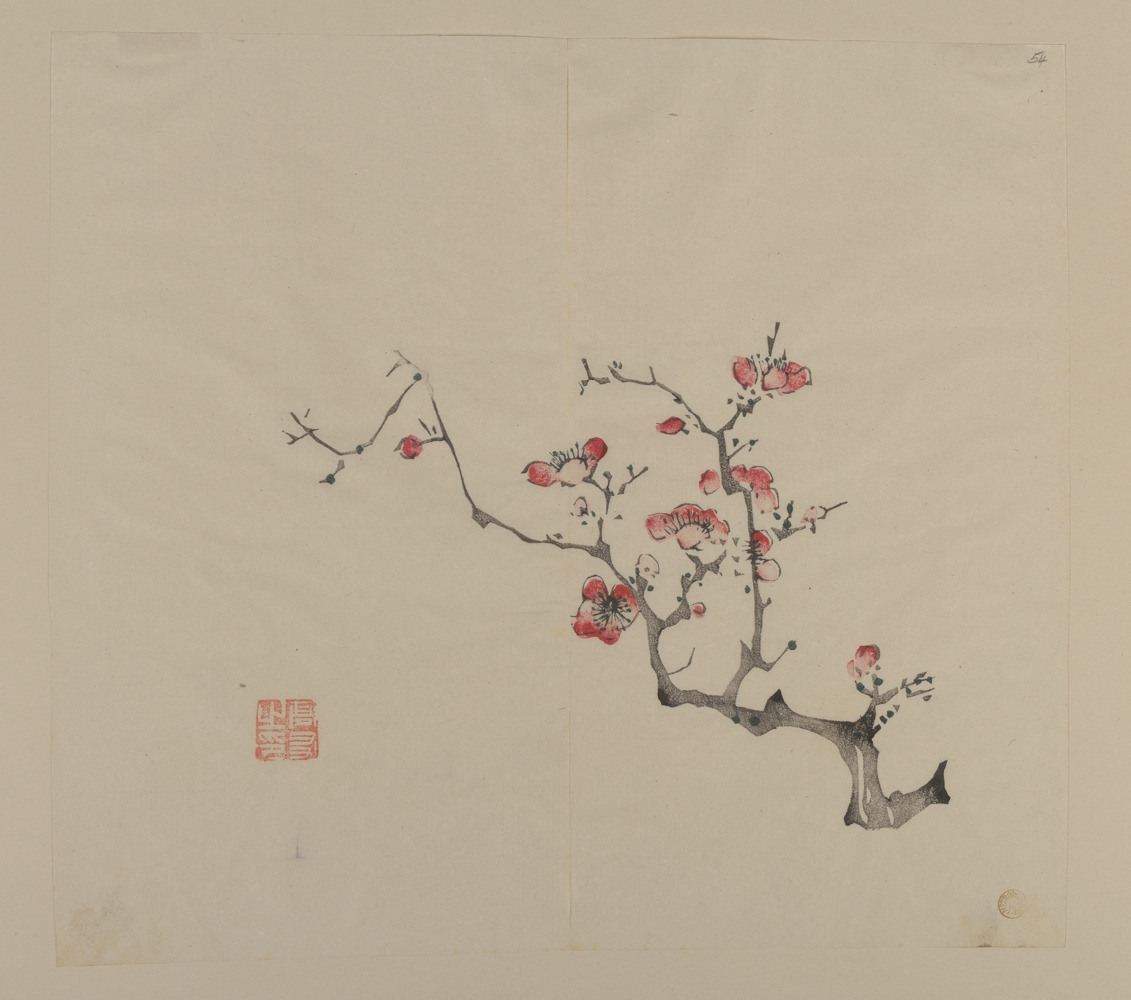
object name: print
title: Page from Shi Zhu Zhai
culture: chinese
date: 1736-1795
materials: ink, paper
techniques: polychrome, woodblock print